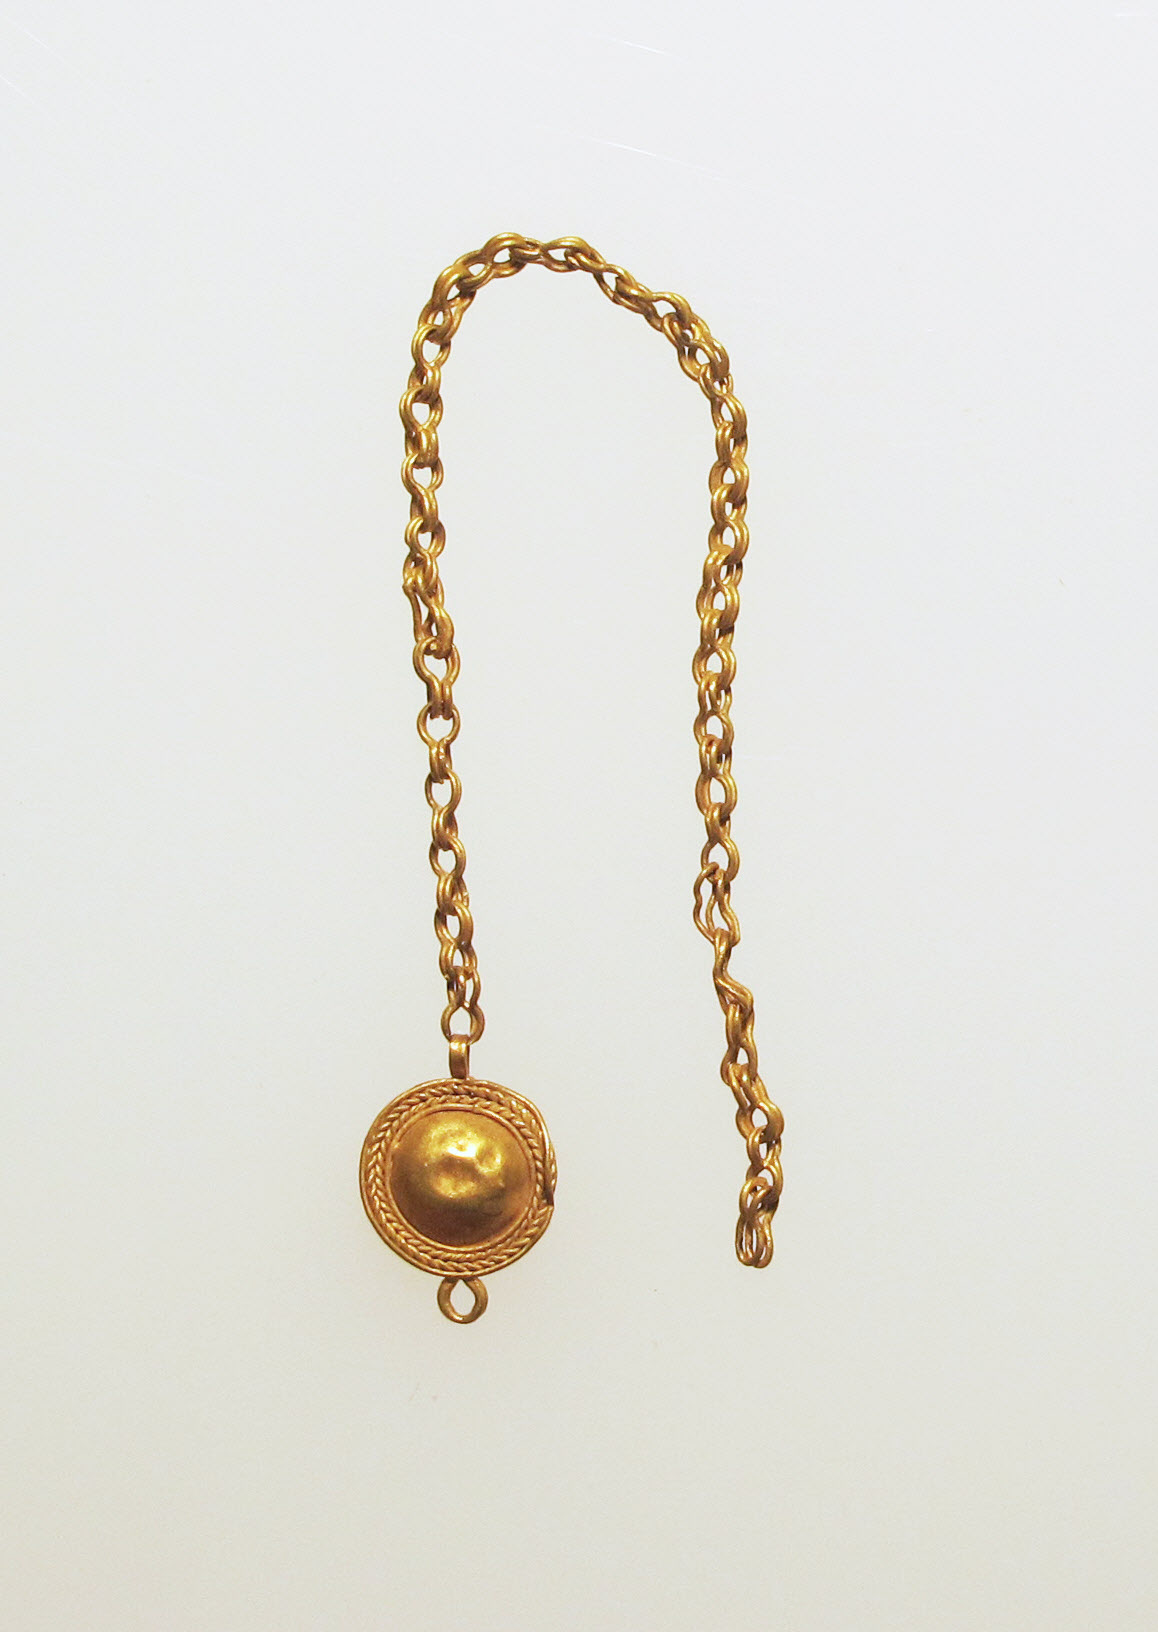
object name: chain earring with disk fastener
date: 7000 BCE-330 CE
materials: gold